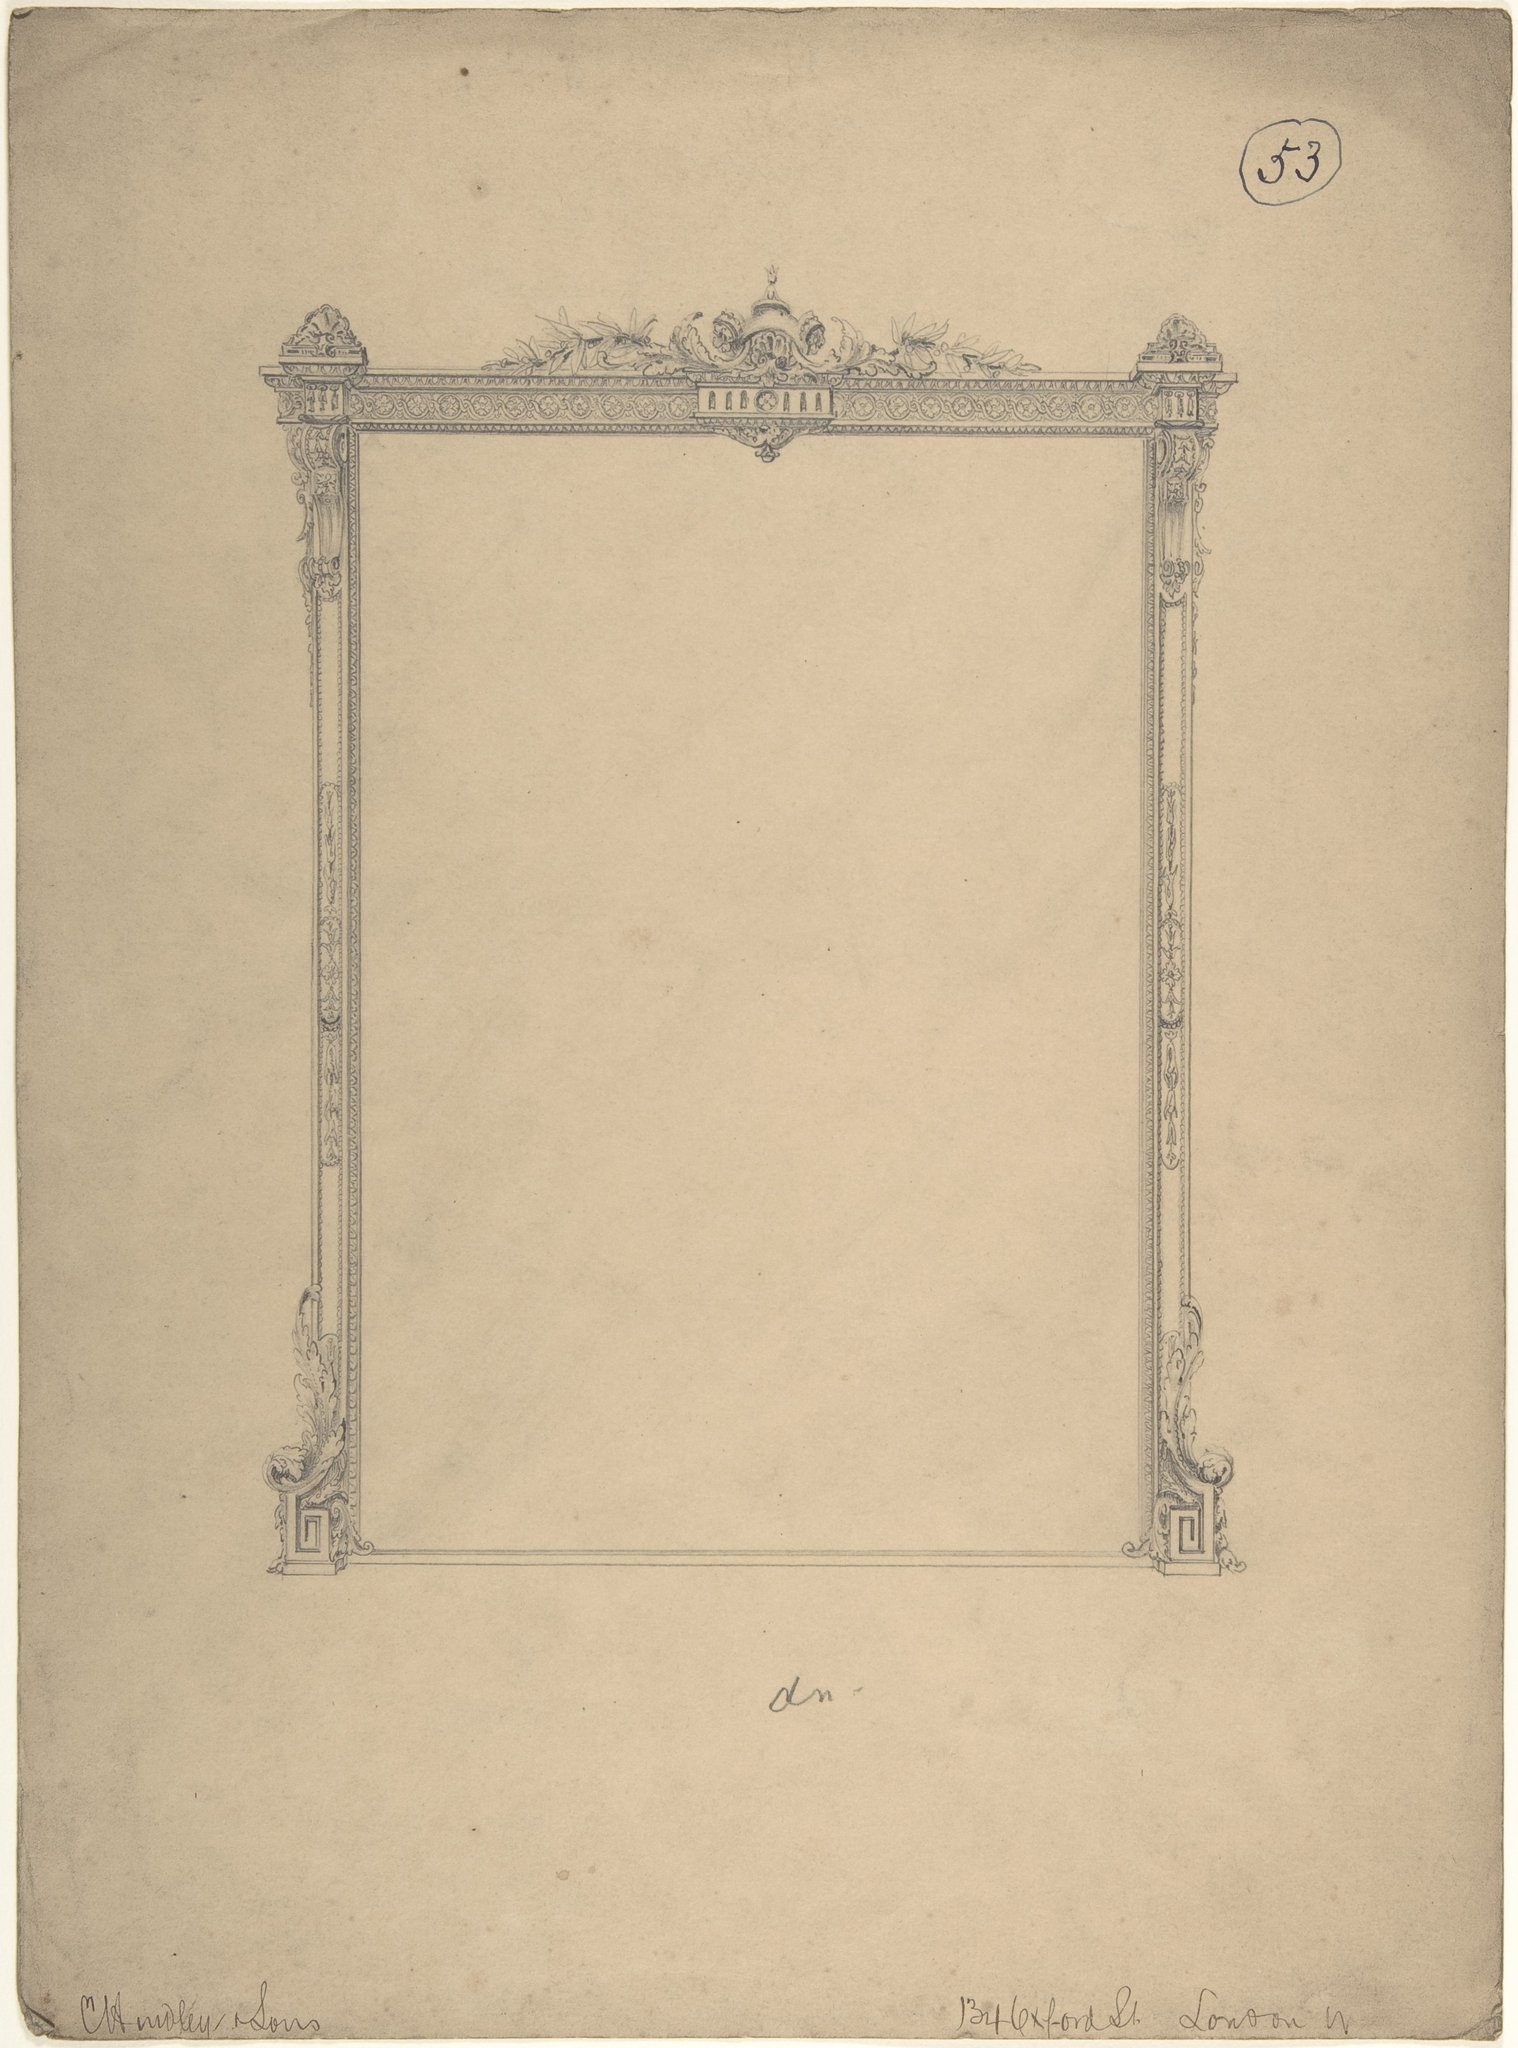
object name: drawing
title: Design for a Frame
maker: charles hindley and sons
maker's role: artist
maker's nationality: british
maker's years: 1841-1917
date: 1841-1884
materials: graphite